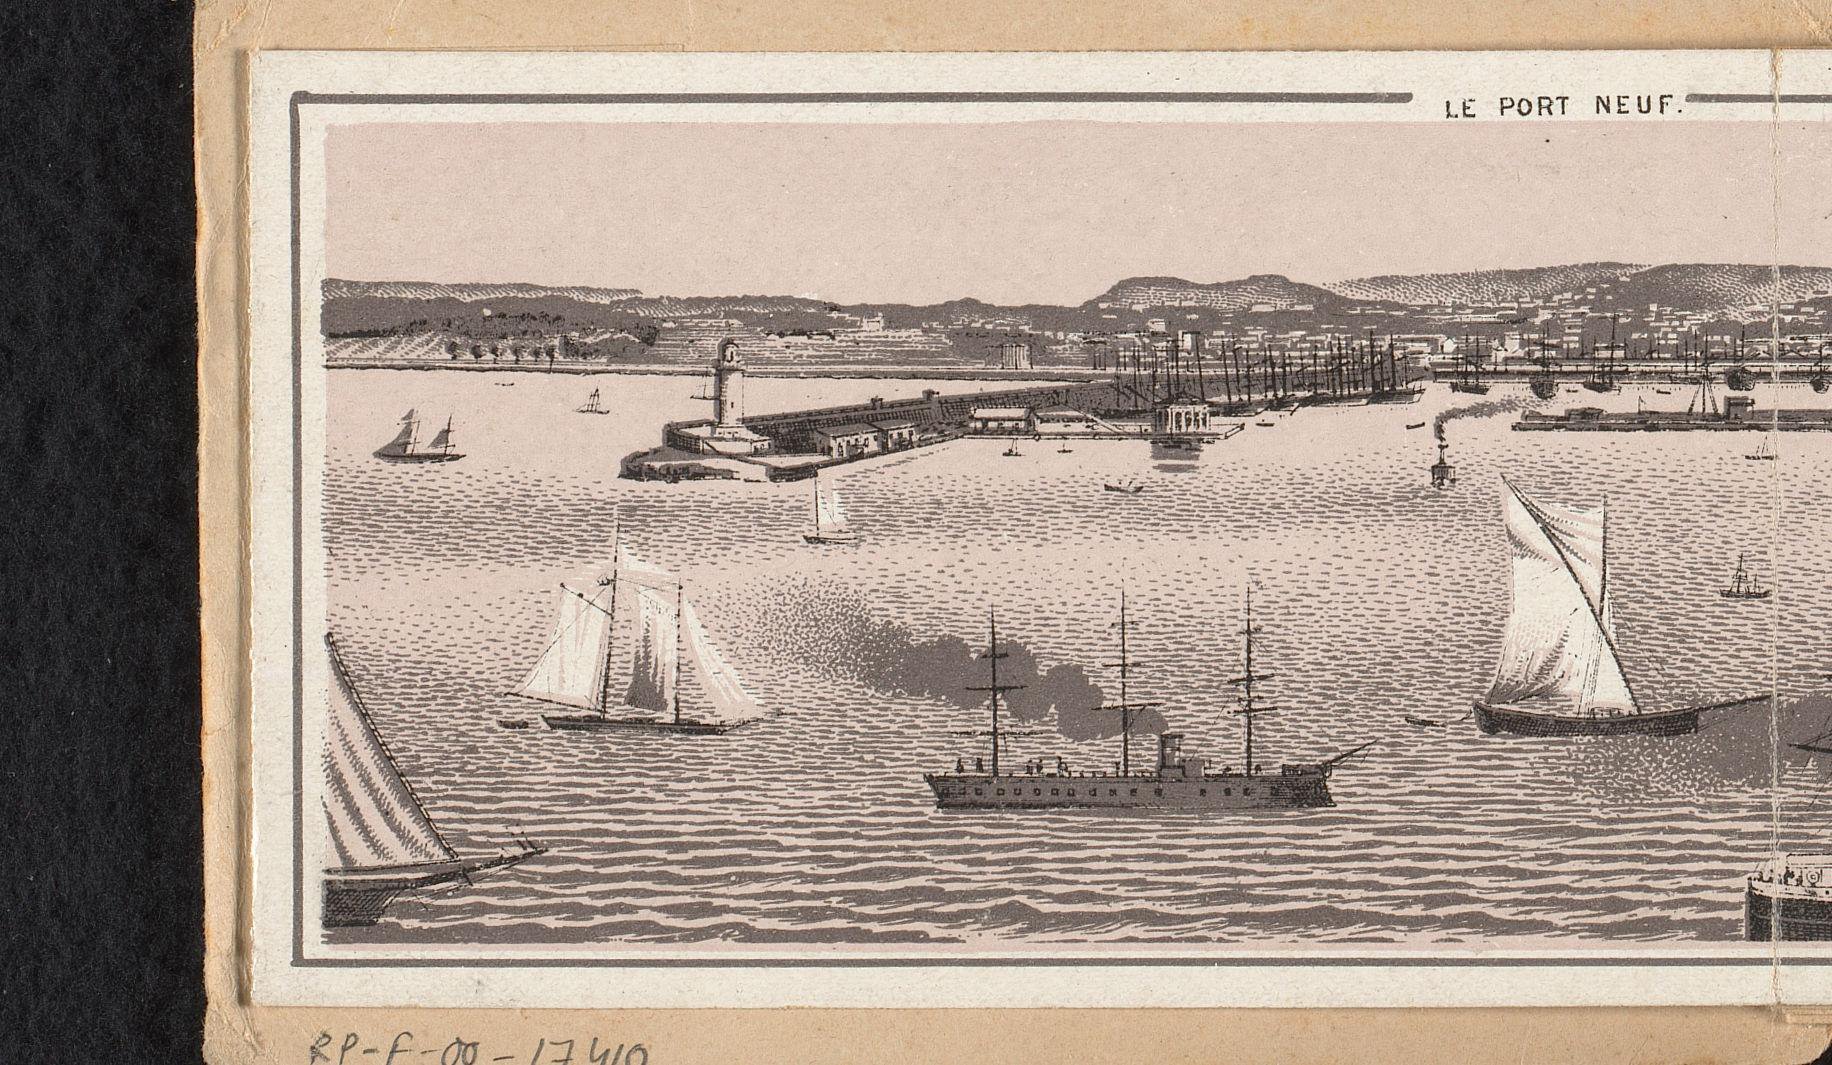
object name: print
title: Le Port Neuf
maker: Anonymous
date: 1890-1910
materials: cardboard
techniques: lithograph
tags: harbour, sailing-ship, sailing-boat, marseille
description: Deze voorstelling vormt samen met drie andere voorstellingen uit dit album een panorama. De overige voorstellingen van dit leporelloalbum staan op zichzelf.